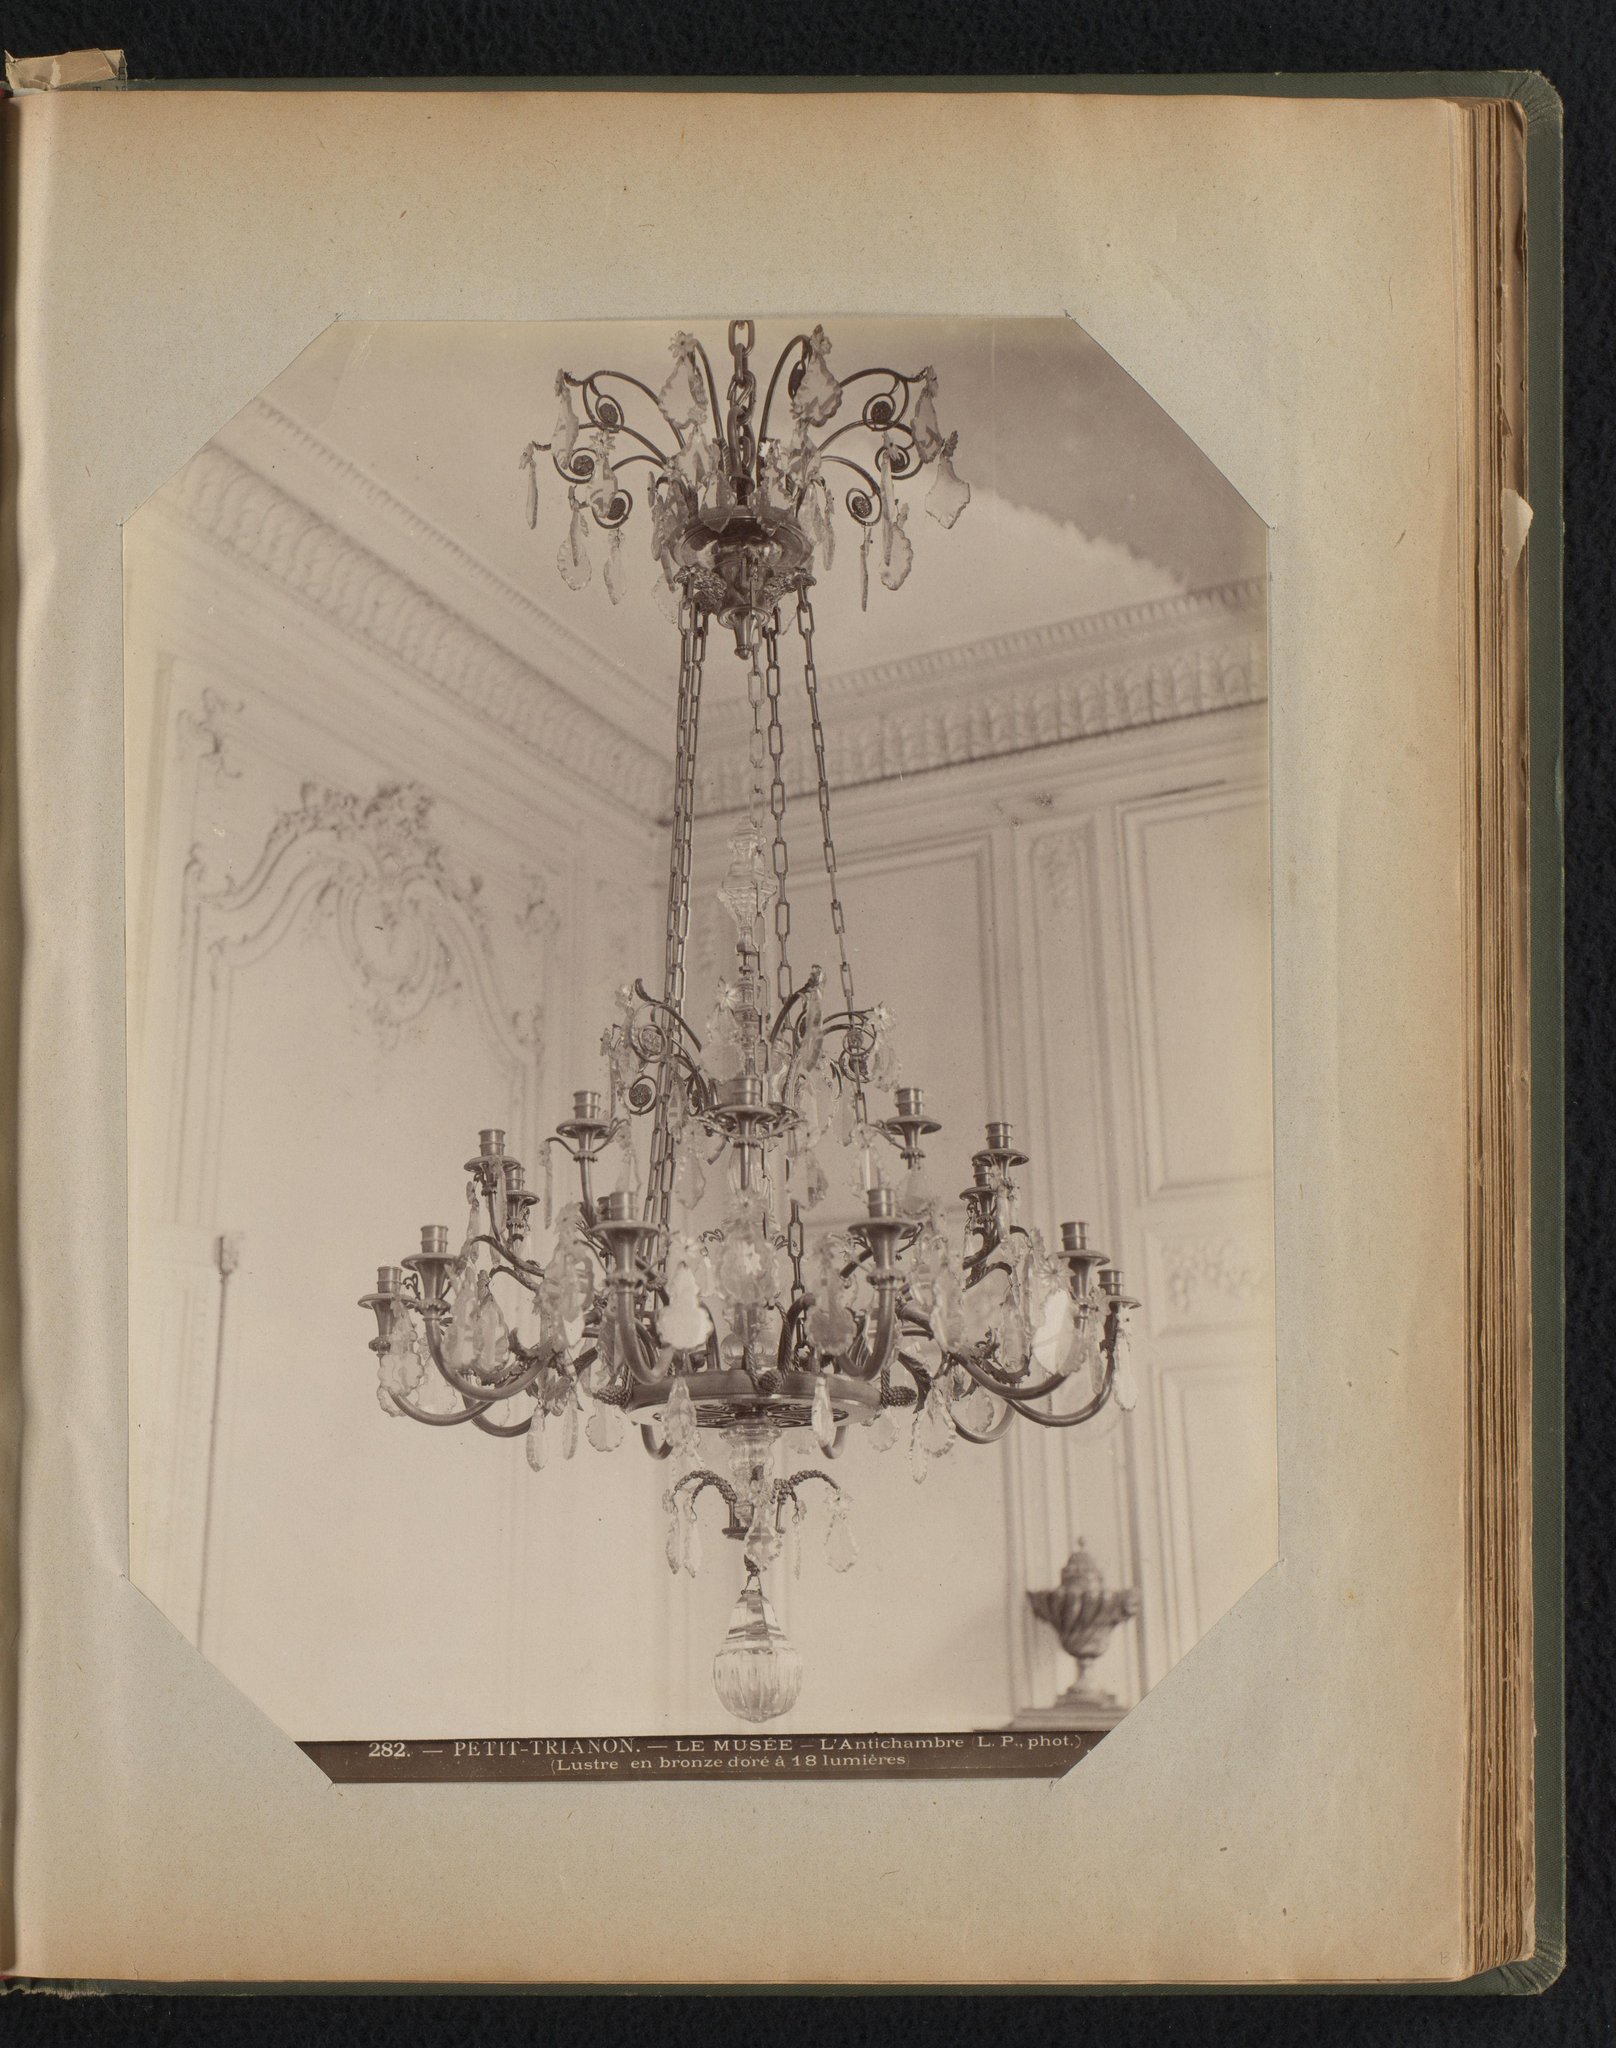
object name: photograph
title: Vergulde bronzen kroonluchter aan het plafond van Petit Trianon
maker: Anonymous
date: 1860-1900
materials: canvas, cardboard, paper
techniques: matte daylight collodion silver print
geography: netherlands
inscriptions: annotation: ‘282. - Petit Trianon. - Le musee - L'Antichambre (L.P. phot) (Lustre en bronze doré a 18 lumieres).’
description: De glazen van de tafellantaarn zijn van elkaar gescheiden door smalle van ornamenten voorziene bronzen pootjes.